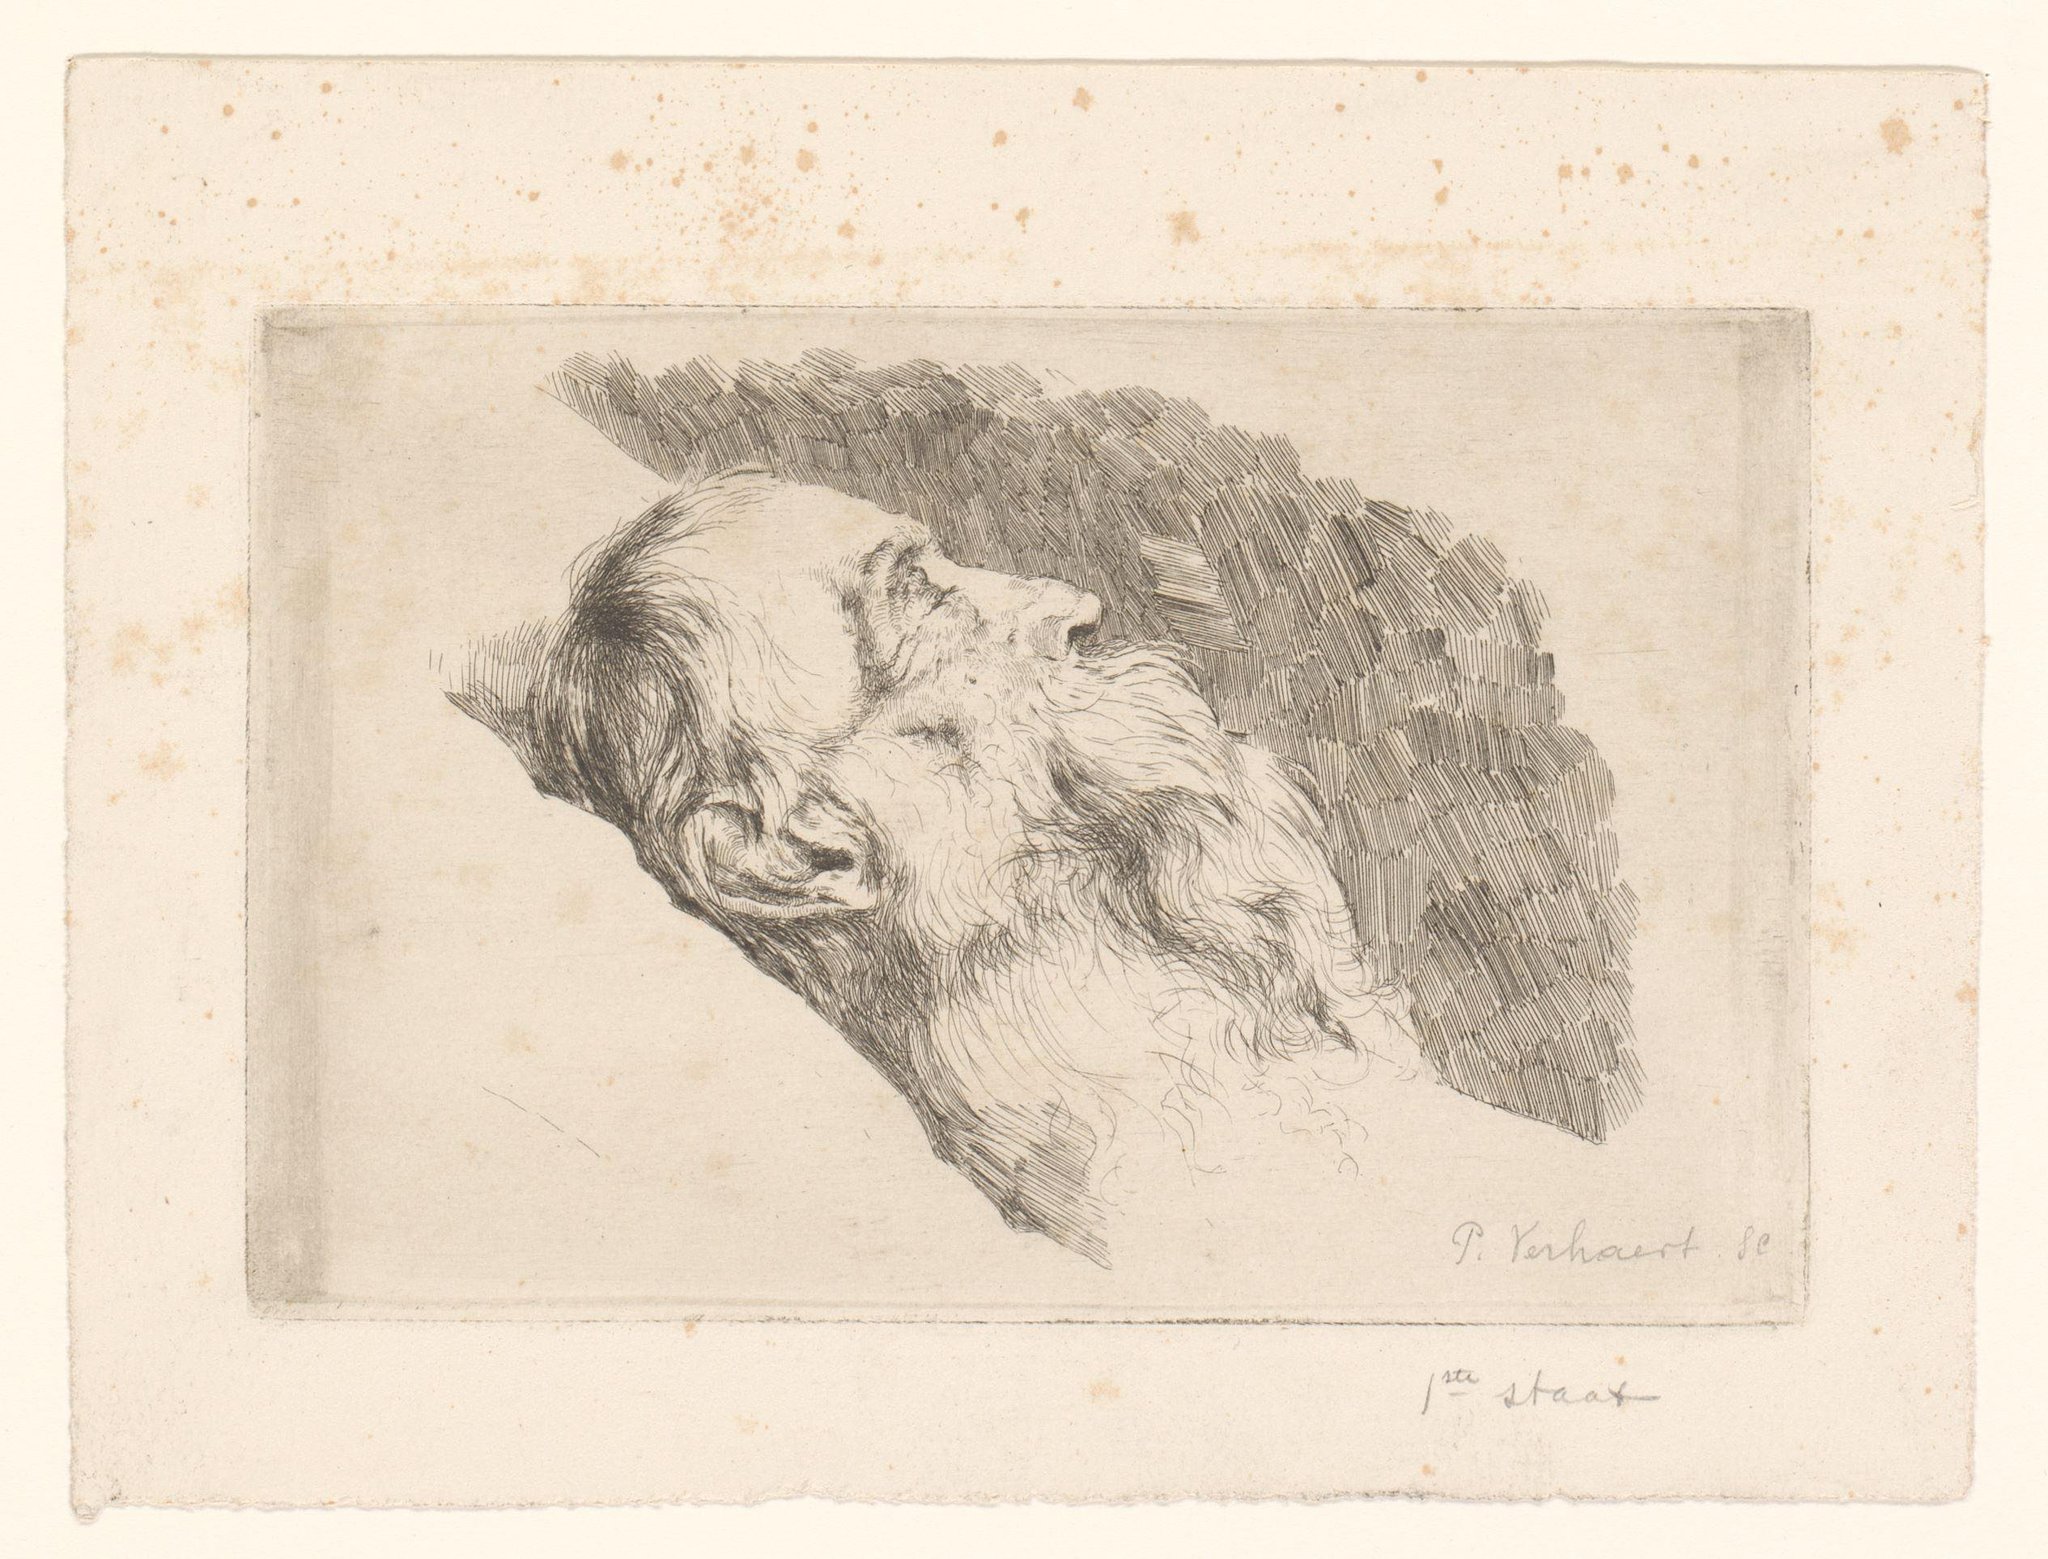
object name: print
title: Hendrik Conscience op zijn doodsbed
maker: piet verhaert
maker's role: print maker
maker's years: 1852-1908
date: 1883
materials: paper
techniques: etching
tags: deathbed, historical persons, beard, lying in state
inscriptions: collector's mark: Lugt 2228, inscription: ‘1ste staat’